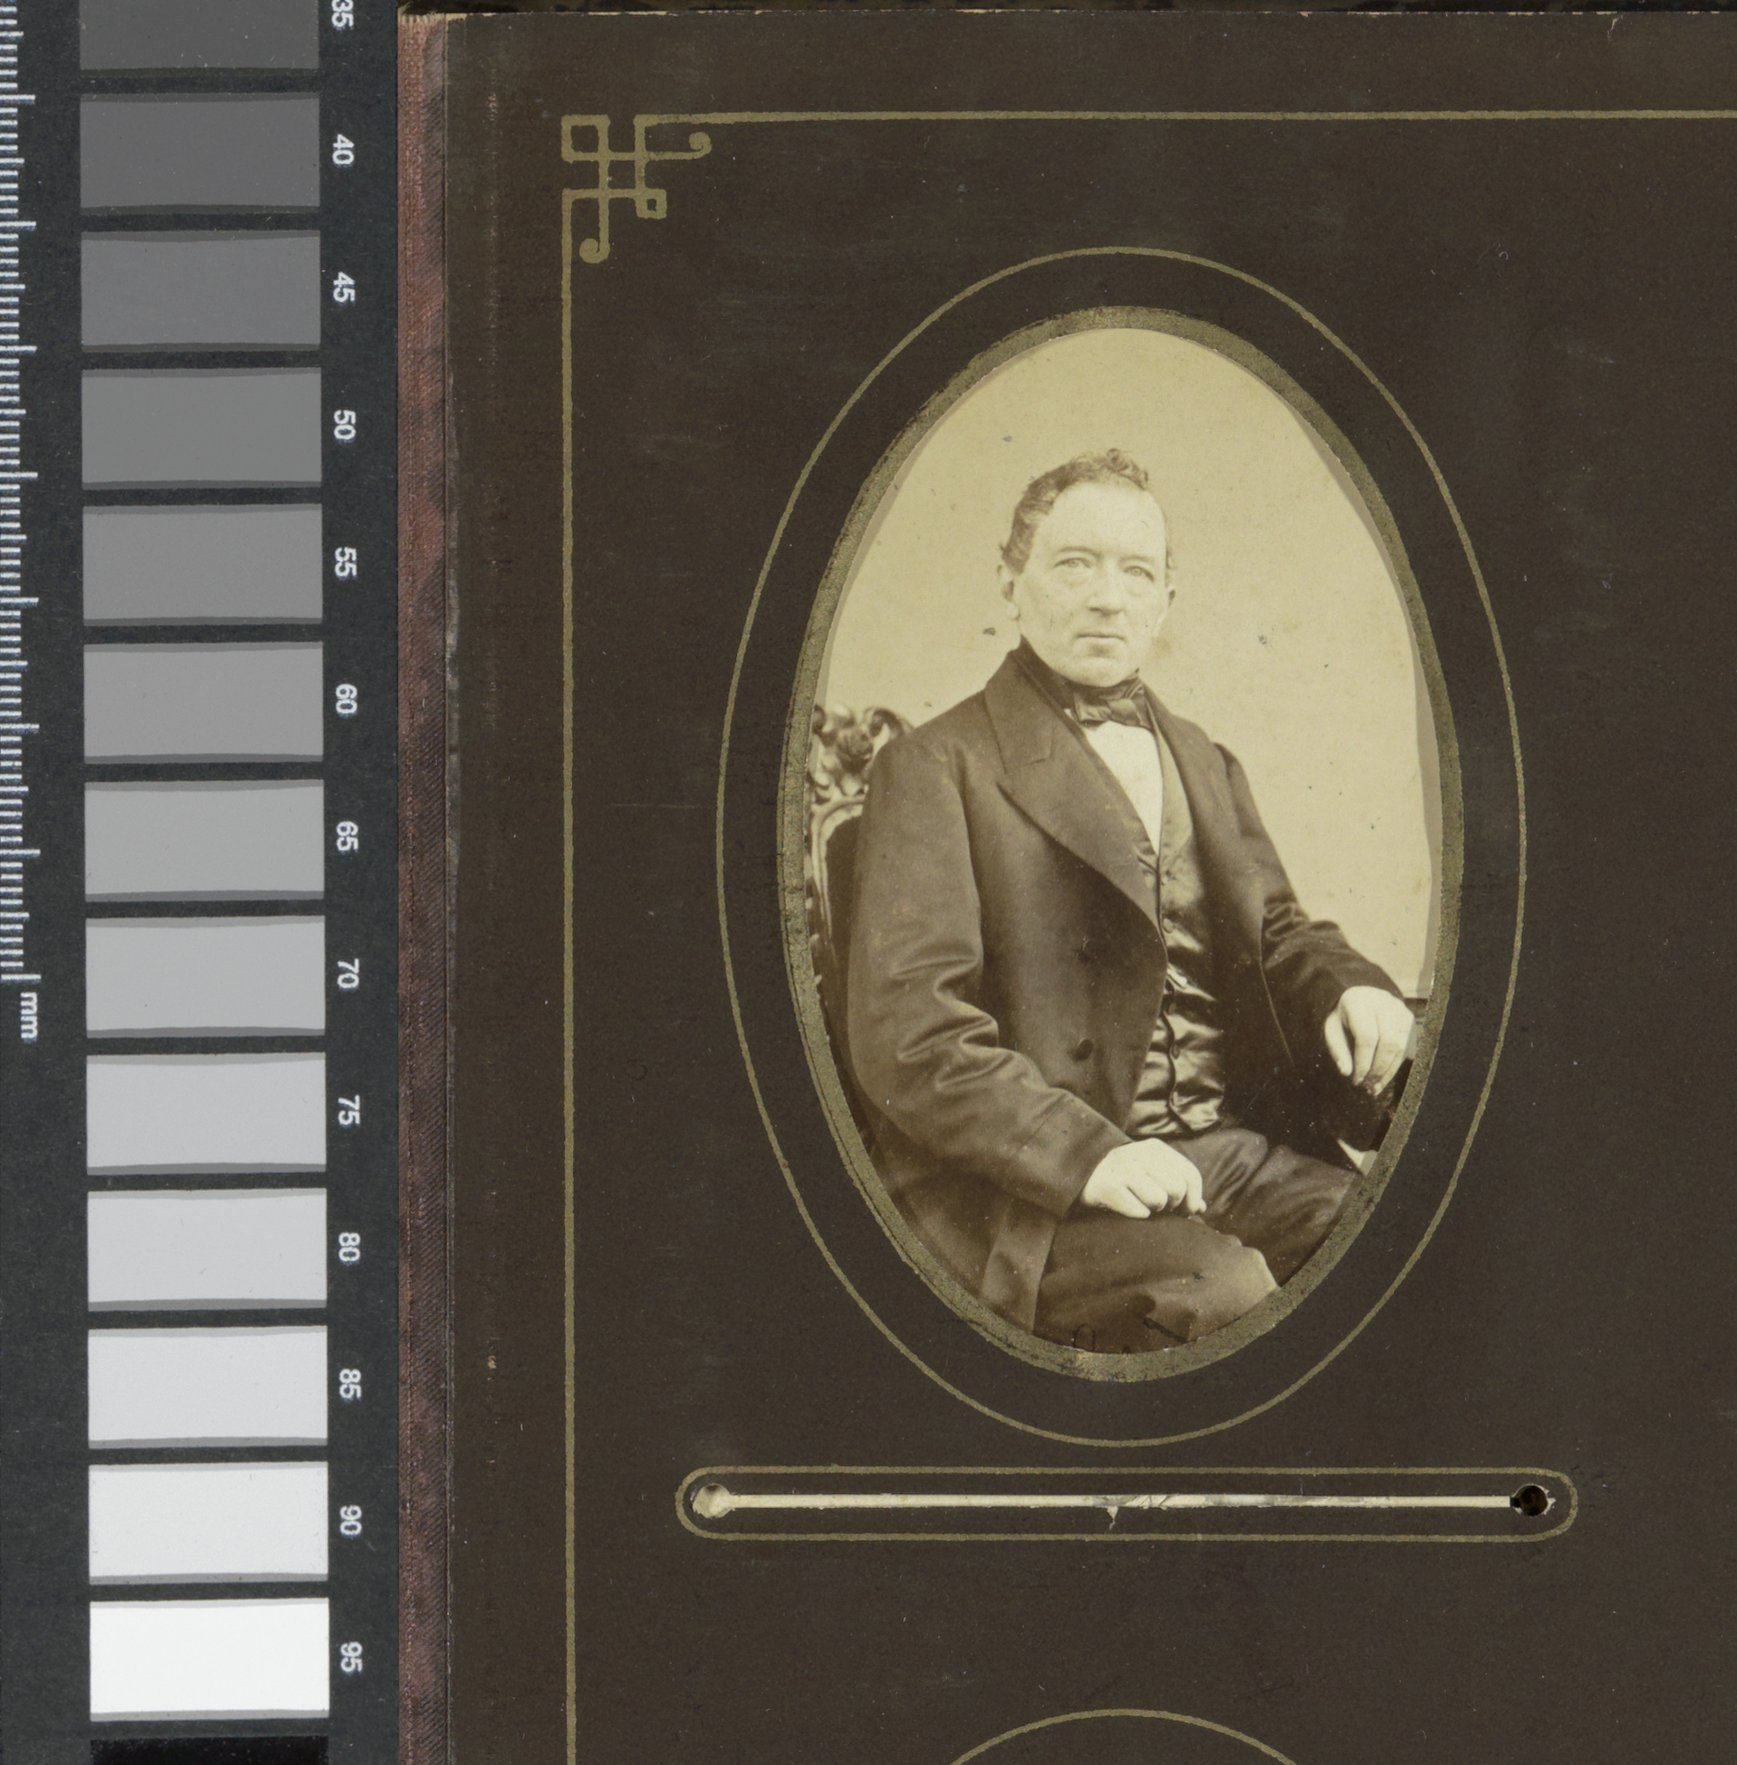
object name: photograph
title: Portret van een man, zittend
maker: maurits verveer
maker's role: painter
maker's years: 1817-1903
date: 1864-1890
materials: cardboard, paper, photographic support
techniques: albumen print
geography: the hague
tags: studio requisites ~ photographer, adult man, historical persons, the hague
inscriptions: address: ‘52. Zeestraat 52, vis á vis du Willemspark, La Haye’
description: Onderdeel van Fotoalbum van de families Matthes, Doorman en Van Thiel.